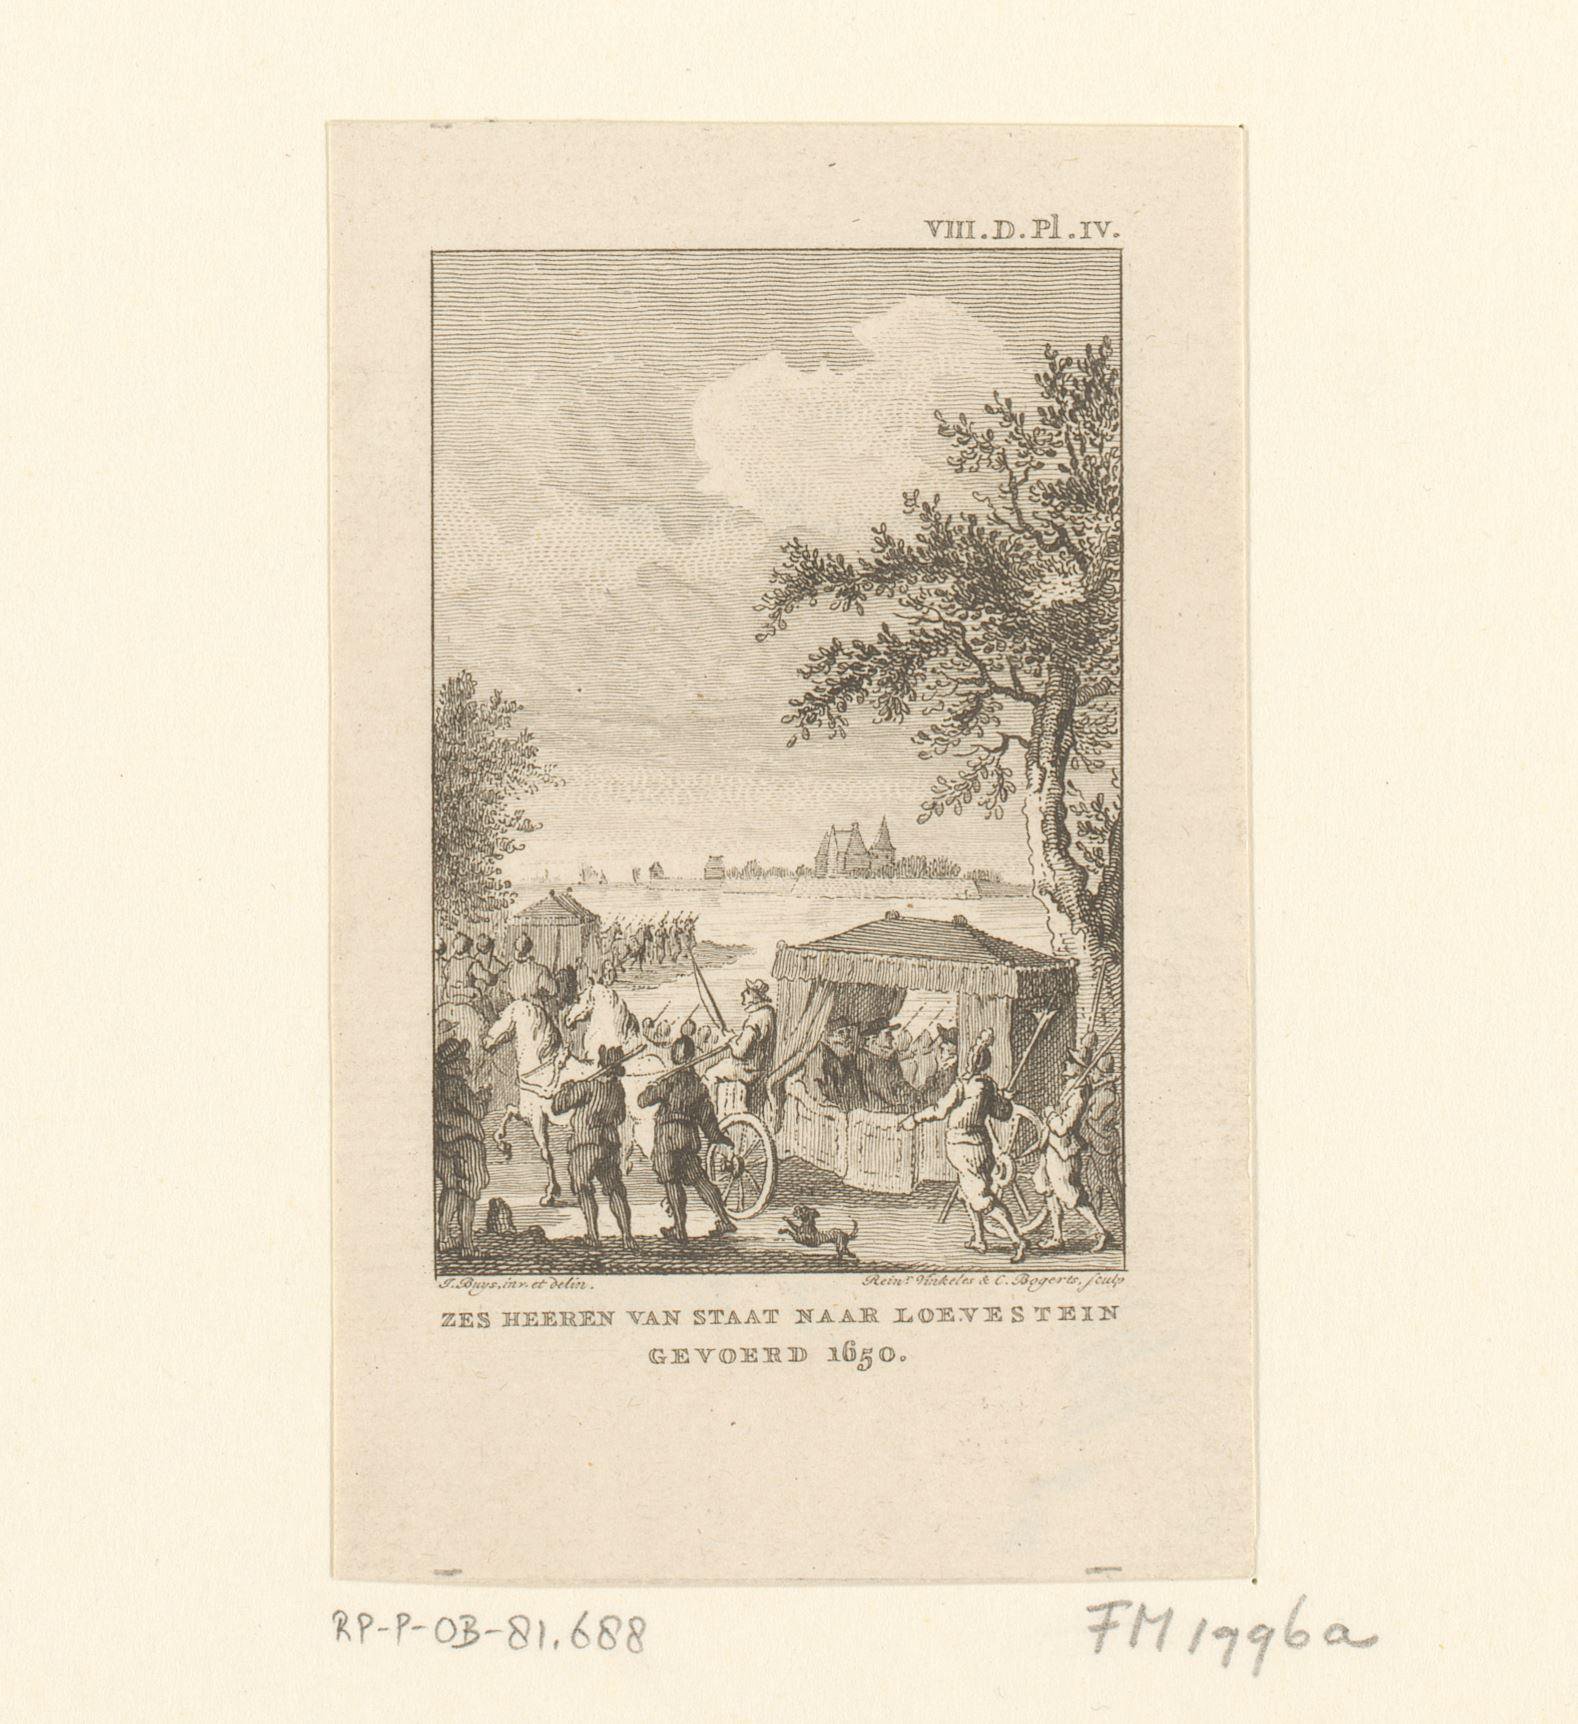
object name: print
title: Gearresteerde statenleden afgevoerd naar Loevestein, 1650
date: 1780-1795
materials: paper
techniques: etching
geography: northern netherlands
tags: william ii (prince of orange), dordrecht, mayor, arrest (of criminal), loevestein castle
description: Gebruikt als illustratie in: J. Fokke, Geschiedenissen der Vereenigde Nederlanden voor de vaderlandsche jeugd, Johannes Allart, Amsterdam 1783-1795, 25 delen, dl. VIII, pl. IV.